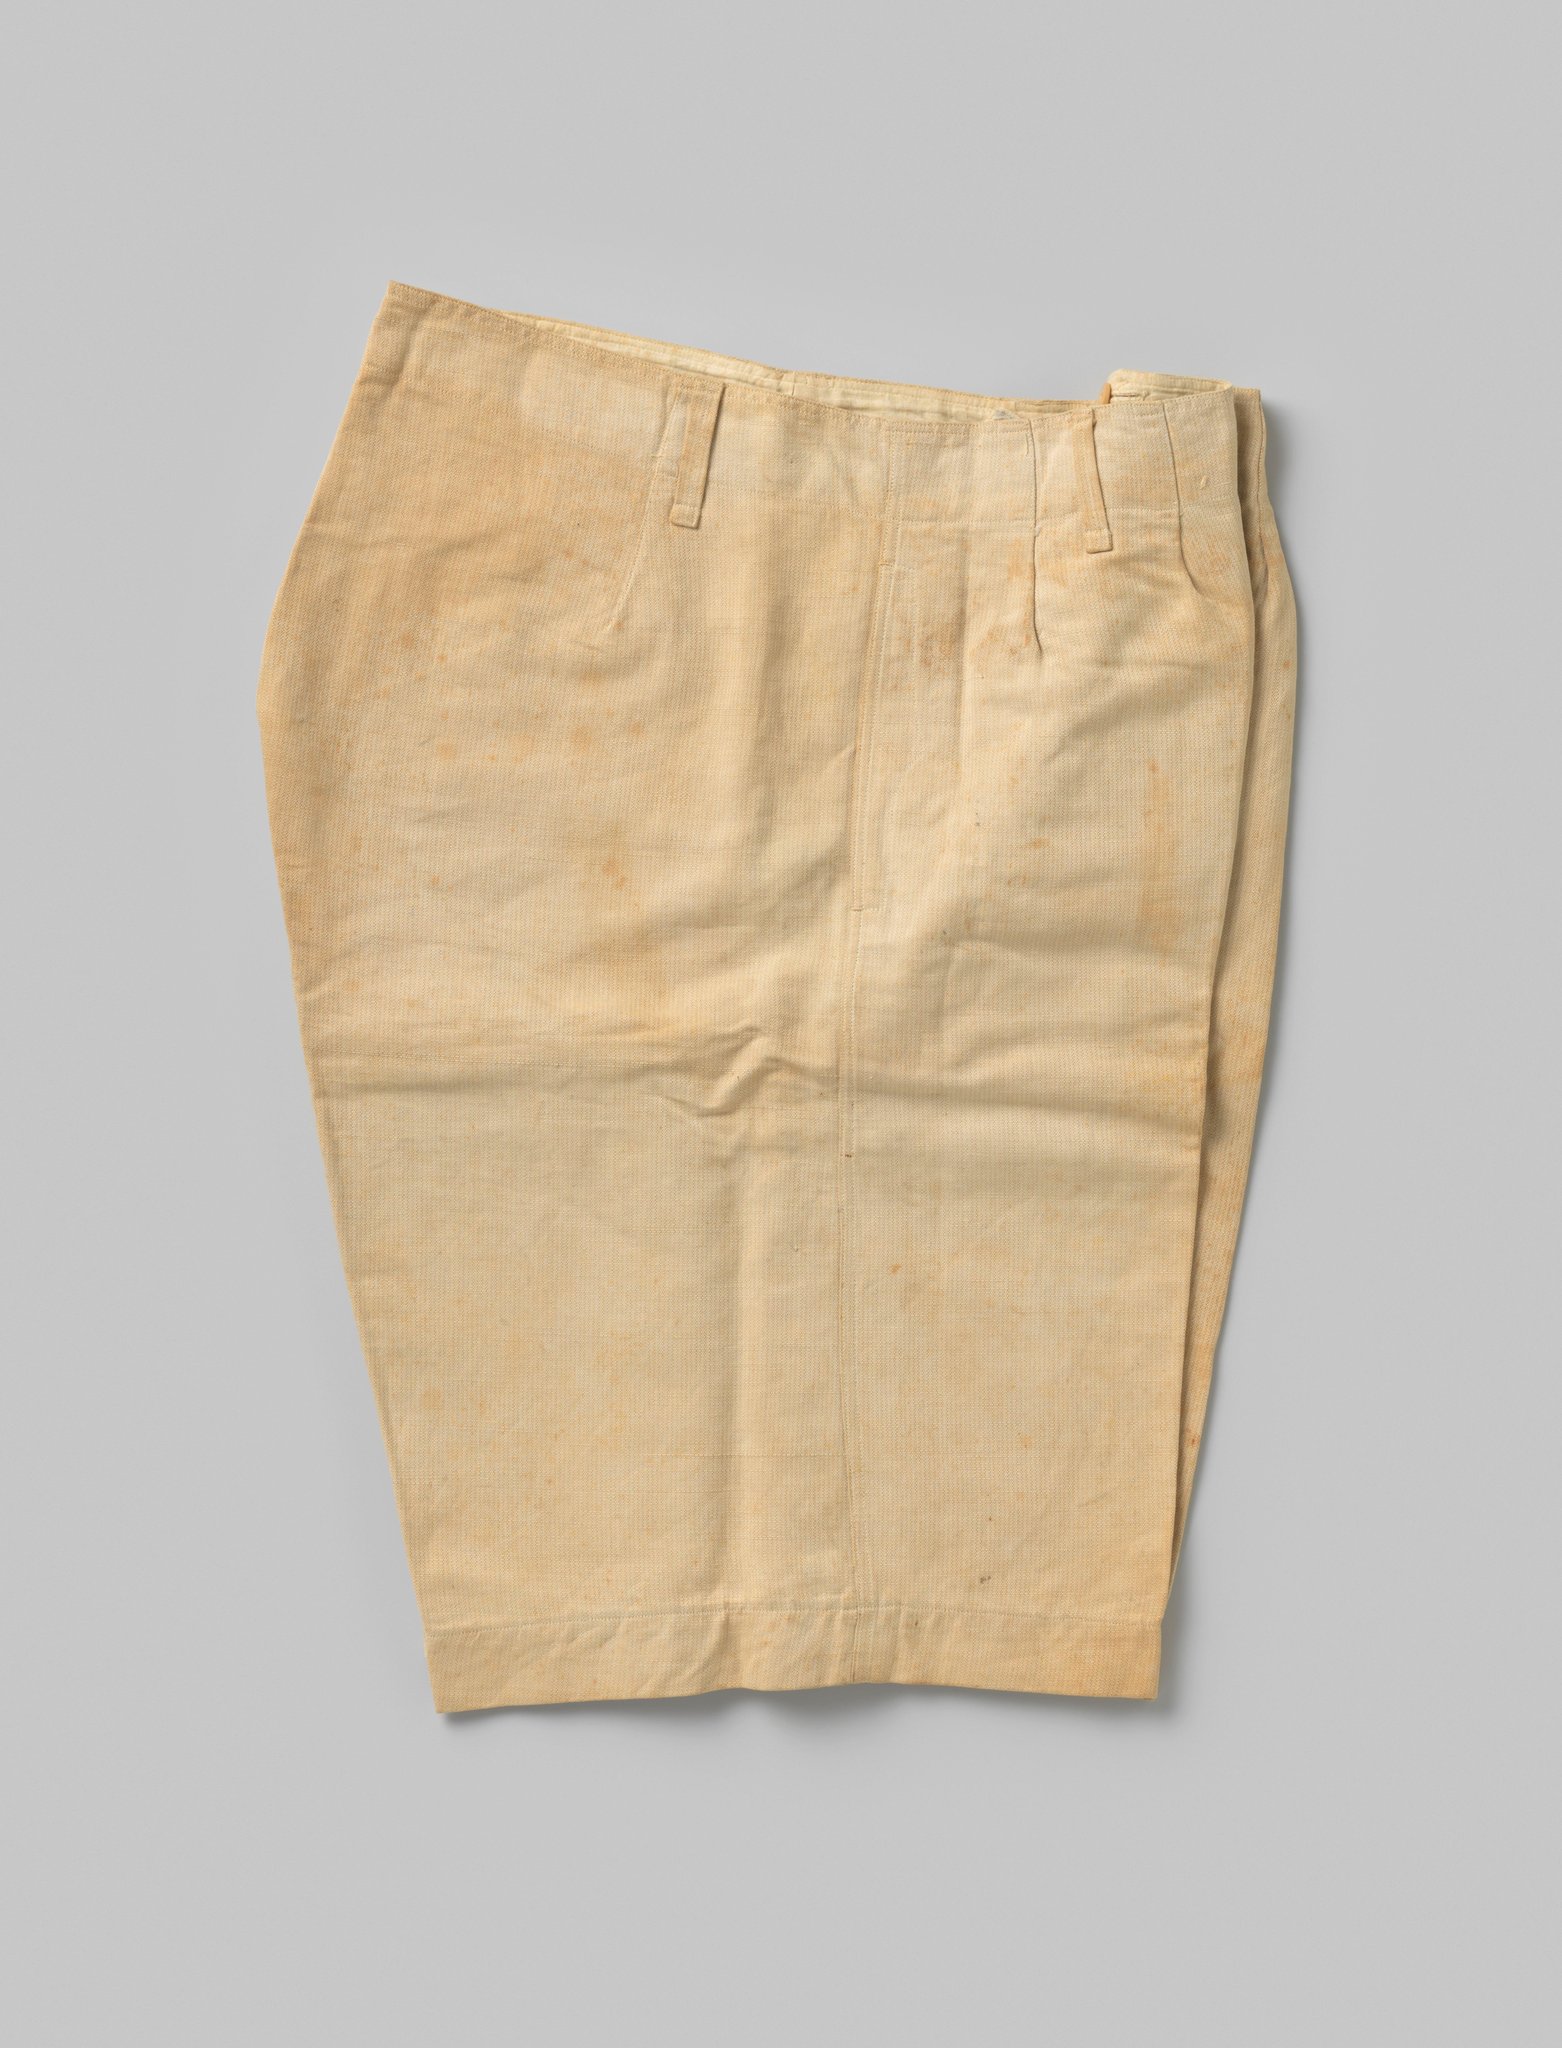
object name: pant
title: Korte broek gedragen door Jhr. Mr. Dr. A.W.L. Tjarda van Starkenborch Stachouwer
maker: ang. savelkout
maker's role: kleermaker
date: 1936-1942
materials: cotton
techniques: stitching, weave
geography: java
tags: politician, dutch east indies, the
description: Broek gedragen door Jhr. Mr. Dr. A.W.L. Tjarda van Starkenborch Stachouwer tijdens zijn internering in Japanse kampen 1942-1945. Vergeelde korte broek van groot formaat, steekzakken en riemlussen. Katoen, ooit gebroken wit of beige.